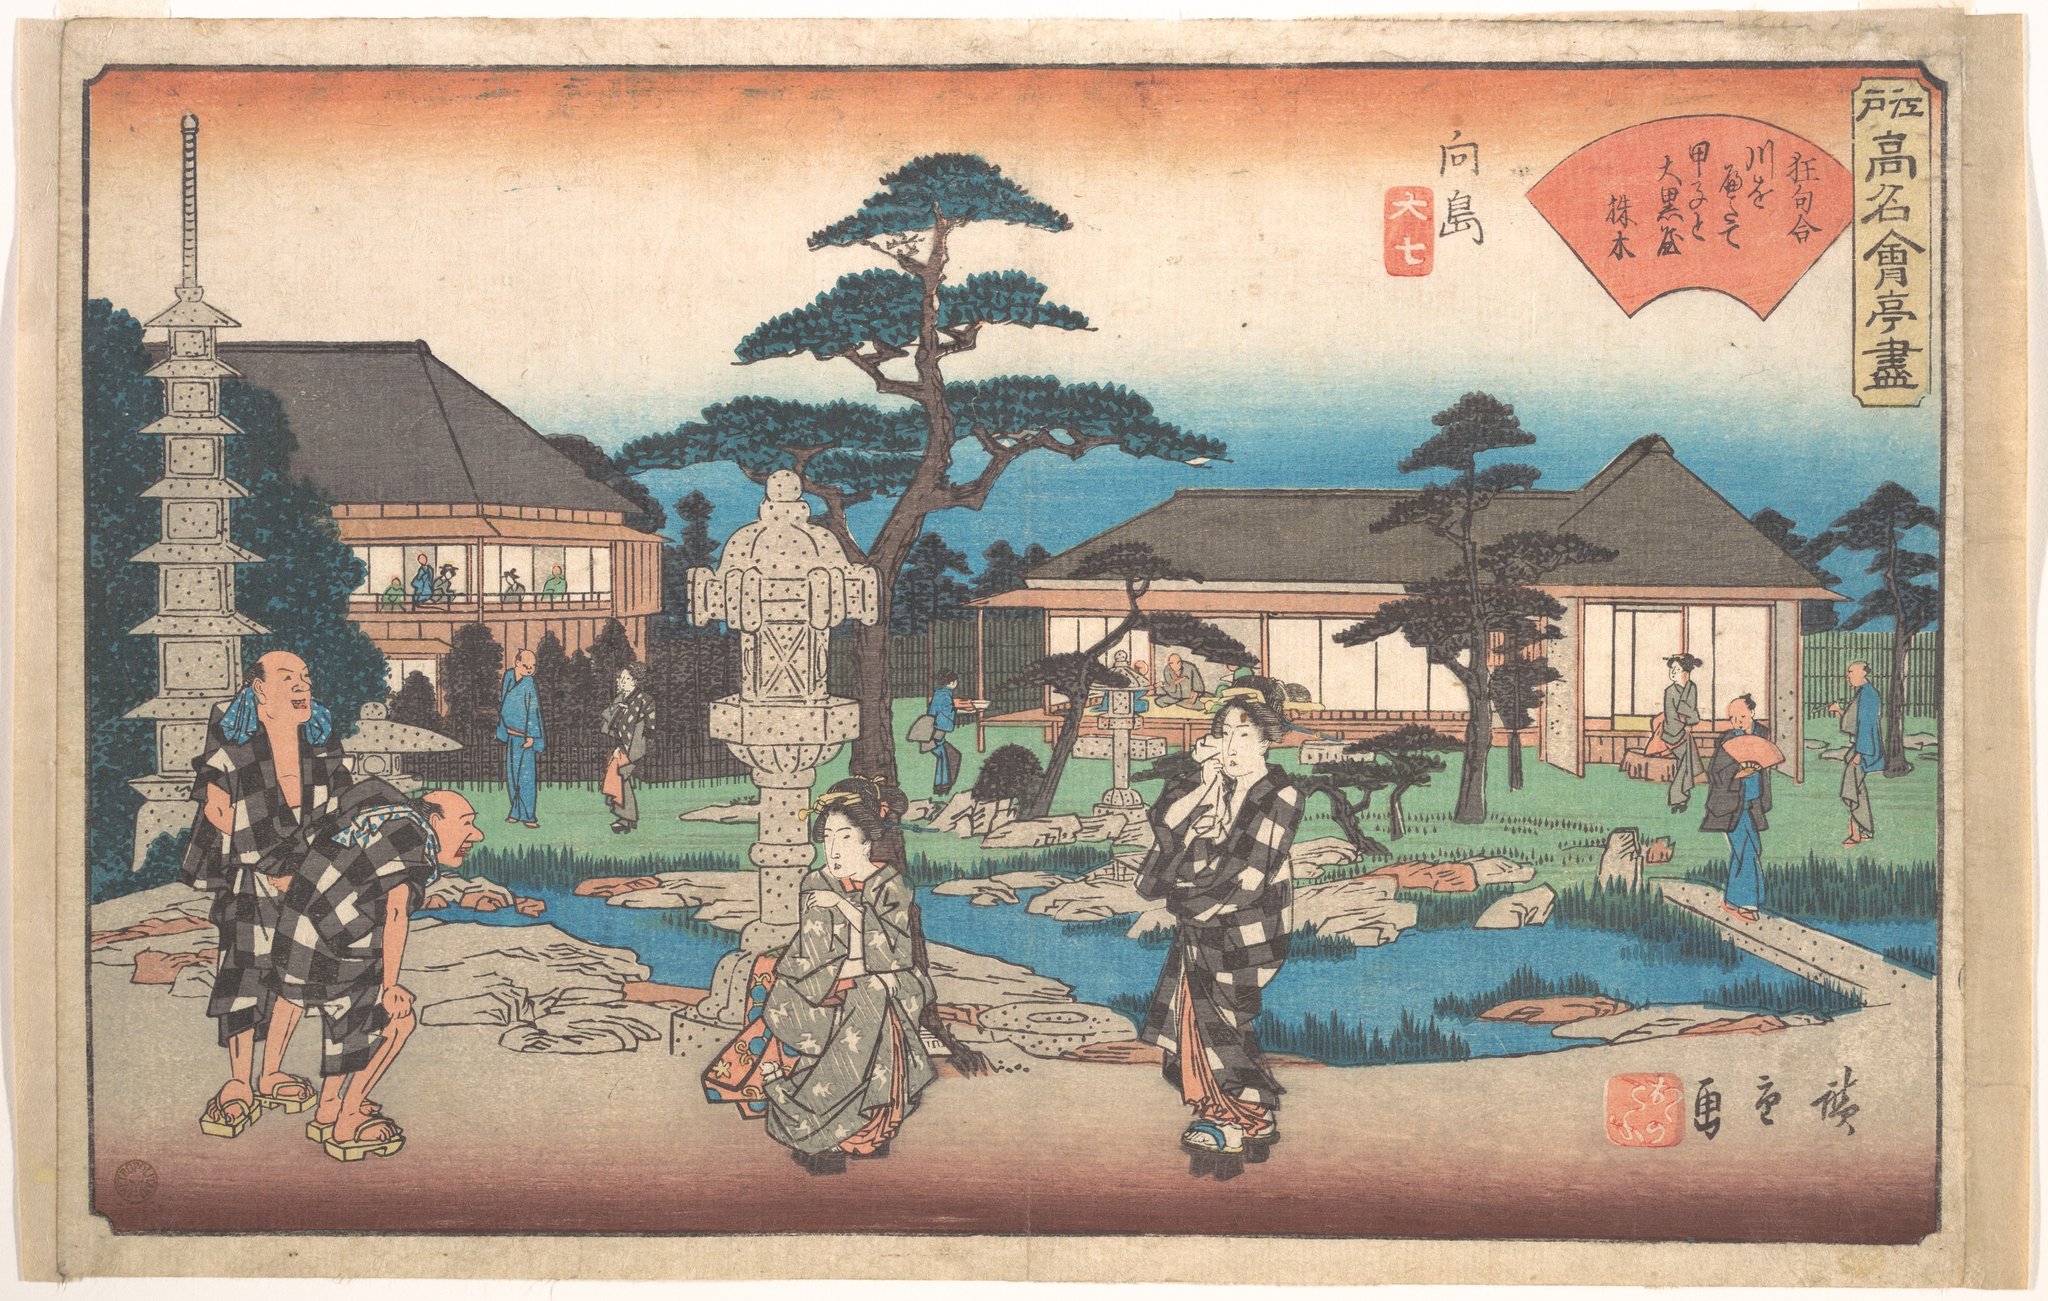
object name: print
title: The Daikokuya at Mukojima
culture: japanese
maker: utagawa hiroshige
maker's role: artist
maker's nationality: japanese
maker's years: 1797-1858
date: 1835-1842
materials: ink, paper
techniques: woodblock print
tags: gardens,men,women